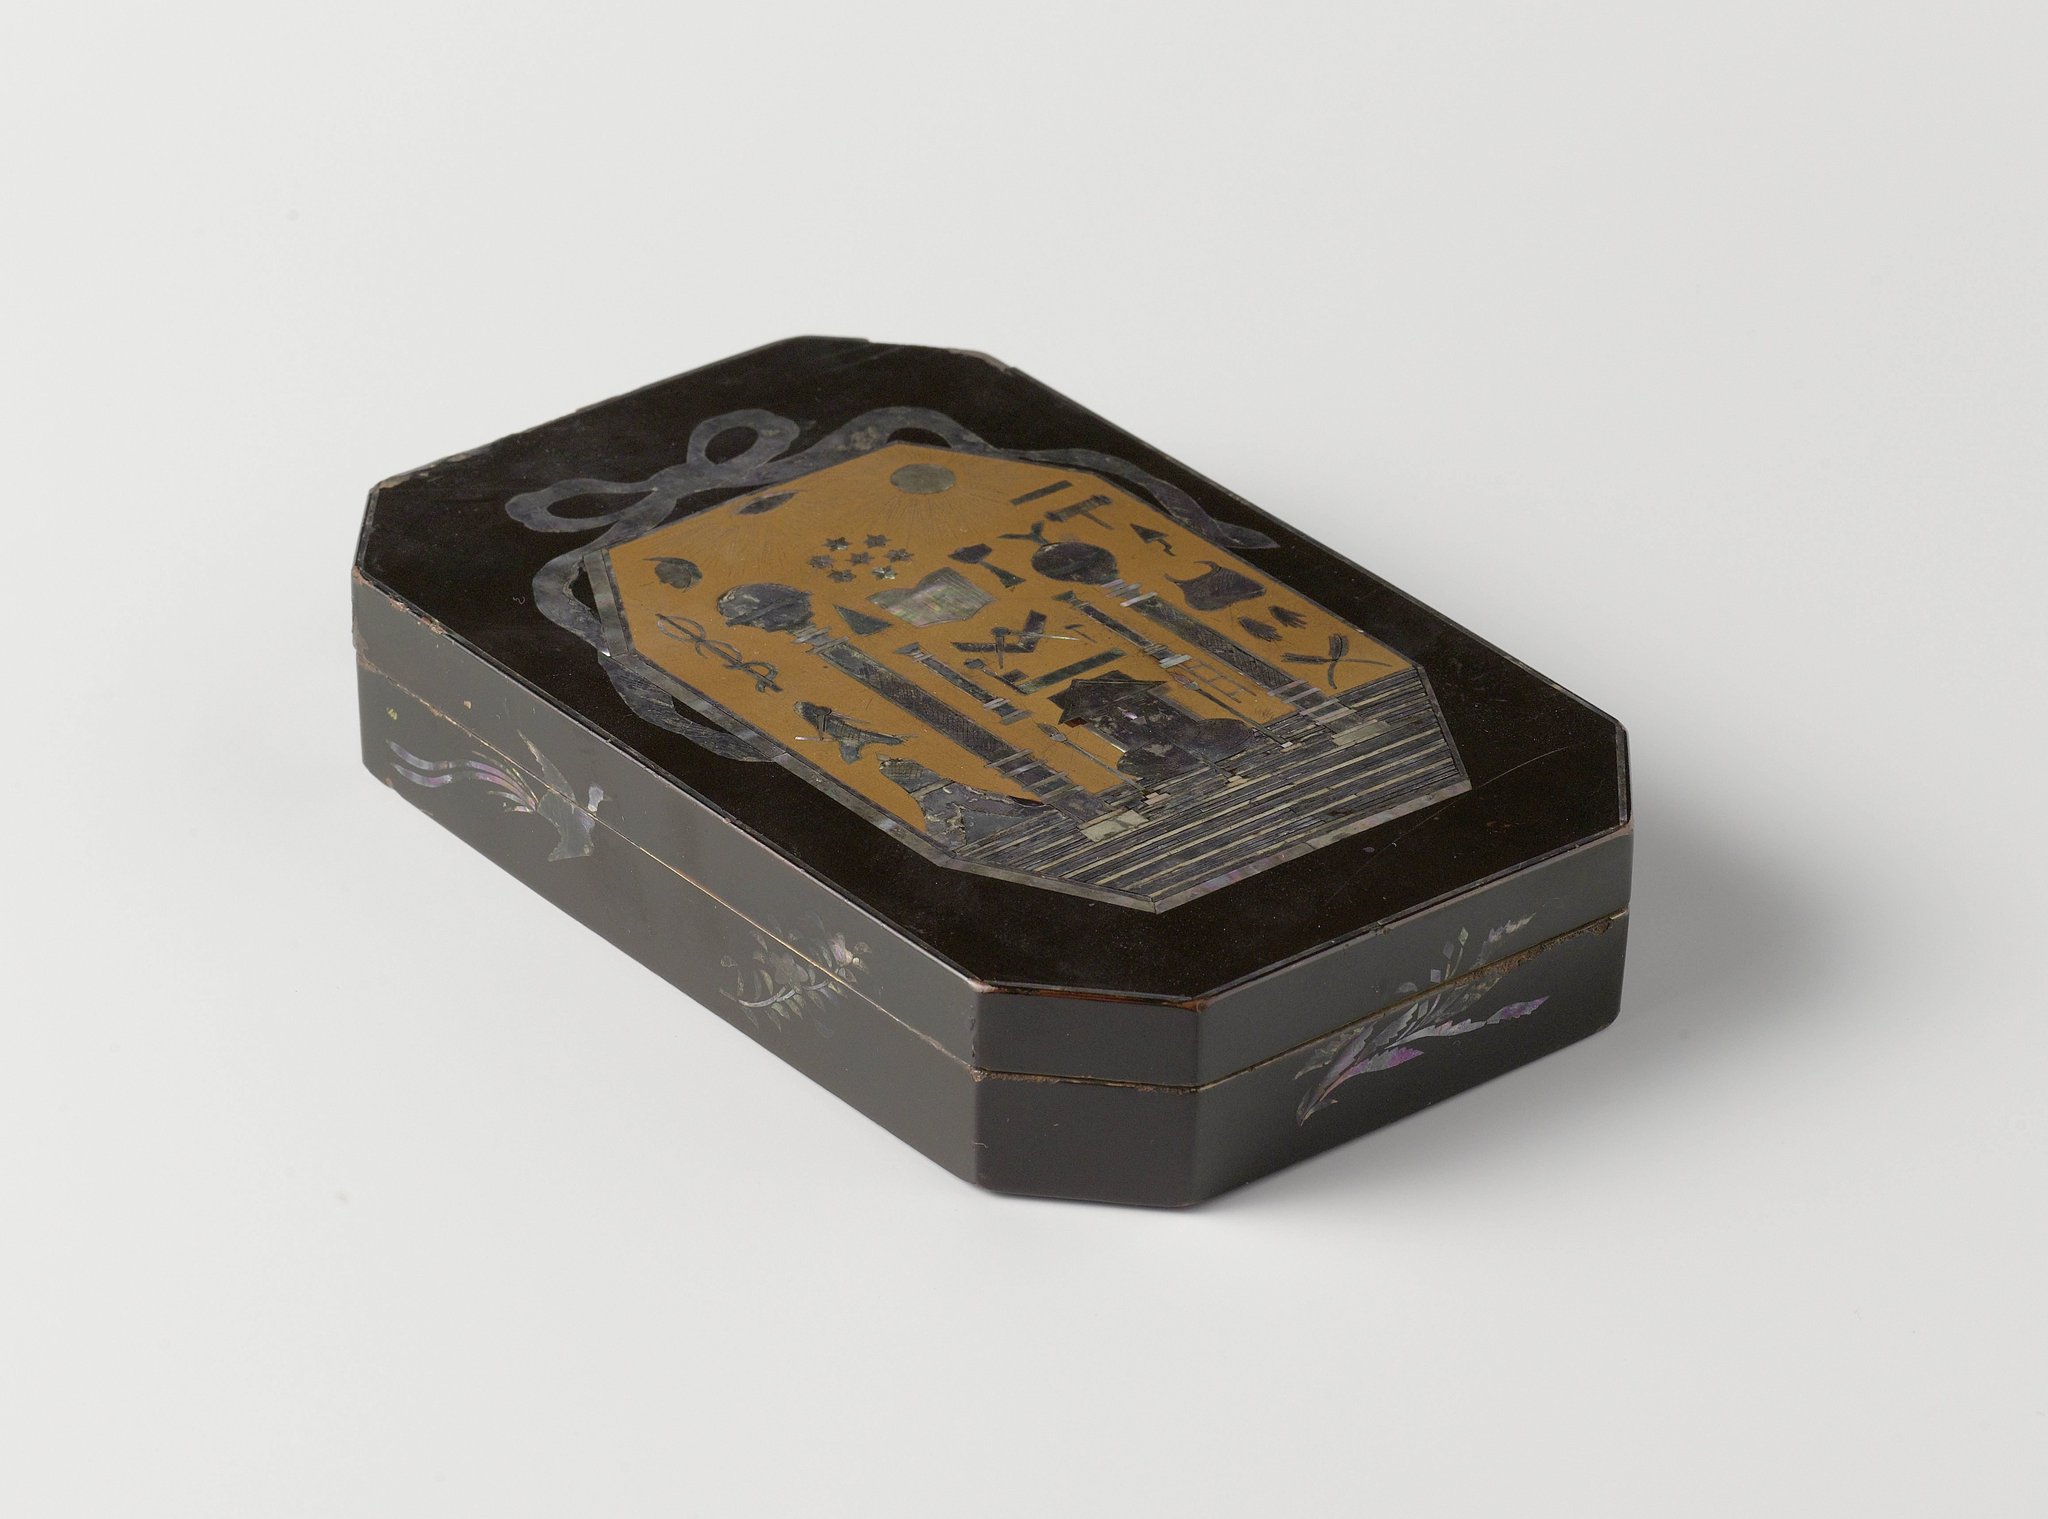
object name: box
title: Doos, rechthoekig met afgeschuinde hoeken, met vrijmetselaarssymbolen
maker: Anonymous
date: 1775-1799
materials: copper, mother of pearl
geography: japan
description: Koperen rechthoekige doos met afgeschuinde hoeken, zwart gelakt. Opde zijkanten vogels en bloemtakken ingelegd in parelmoer. Op de deksel een rechthoekig veld met afgeschuinde hoeken, waarin ingelegd in parelmoer vrijmetselaarssymbolen, deels op een gestreepte grond staande: zuilen met een wereldbol erop, zon, maan, alziend oog, sterren, mercuriusstaf, passers etc. Het veld is omlijst door een parelmoeren band en aan de bovenkant versierd met een gestrikt lint in parelmoer.